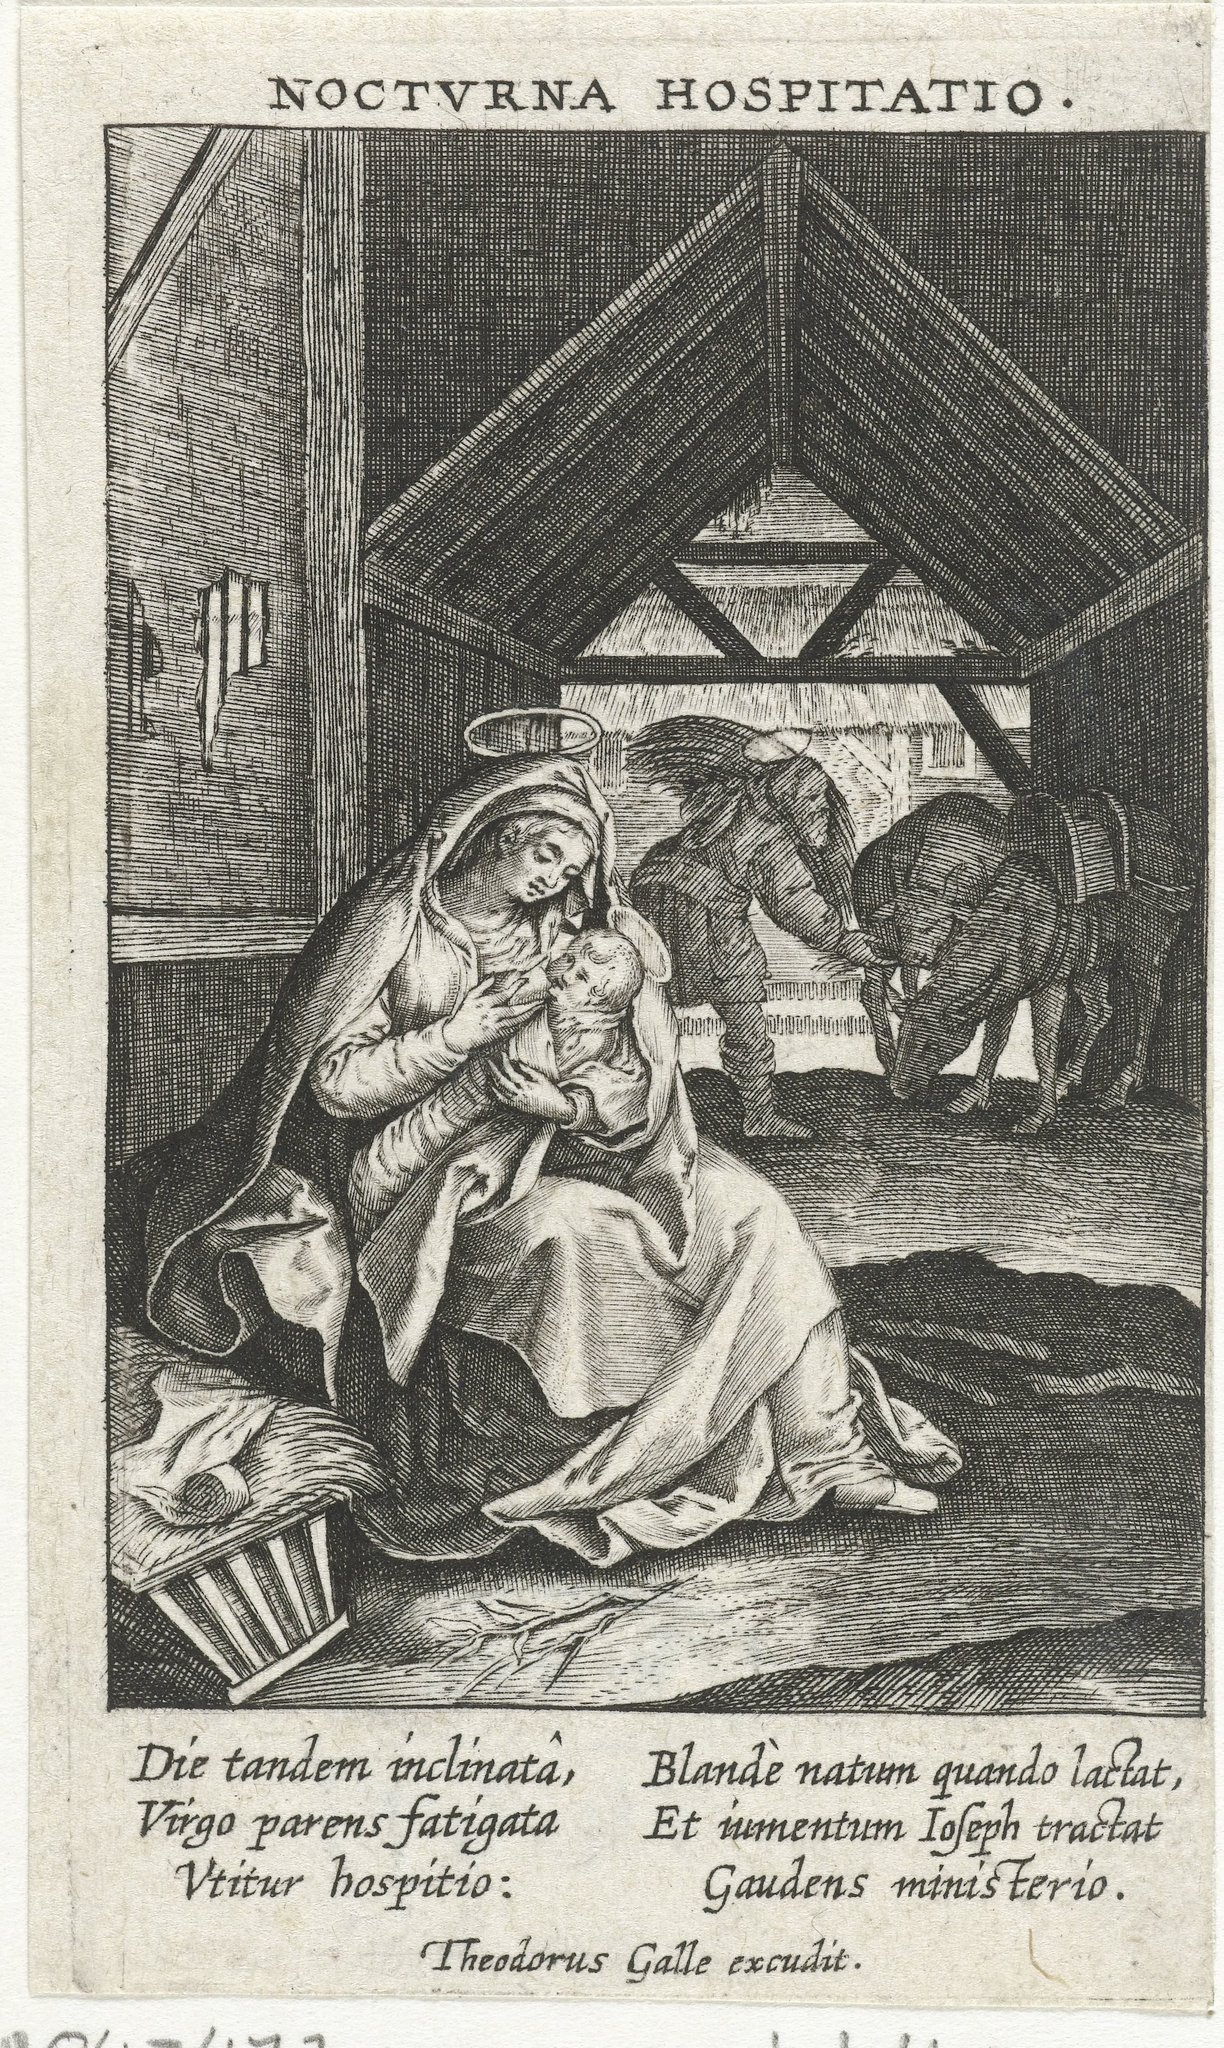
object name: print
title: Geboorte van Christus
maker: theodoor galle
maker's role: print maker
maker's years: 1571-1633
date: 1581-1633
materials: paper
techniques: engraving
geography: antwerp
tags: mary, joseph and the new-born christ (nativity)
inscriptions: collector's mark: Lugt 2228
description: Maria met het Christuskind op de voorgrond. Jozef geeft de os en de ezel te eten. De prent heeft een Latijns onderschrift en maakt deel uit van een zestiendelige serie met taferelen uit het leven van de Heilige Familie.